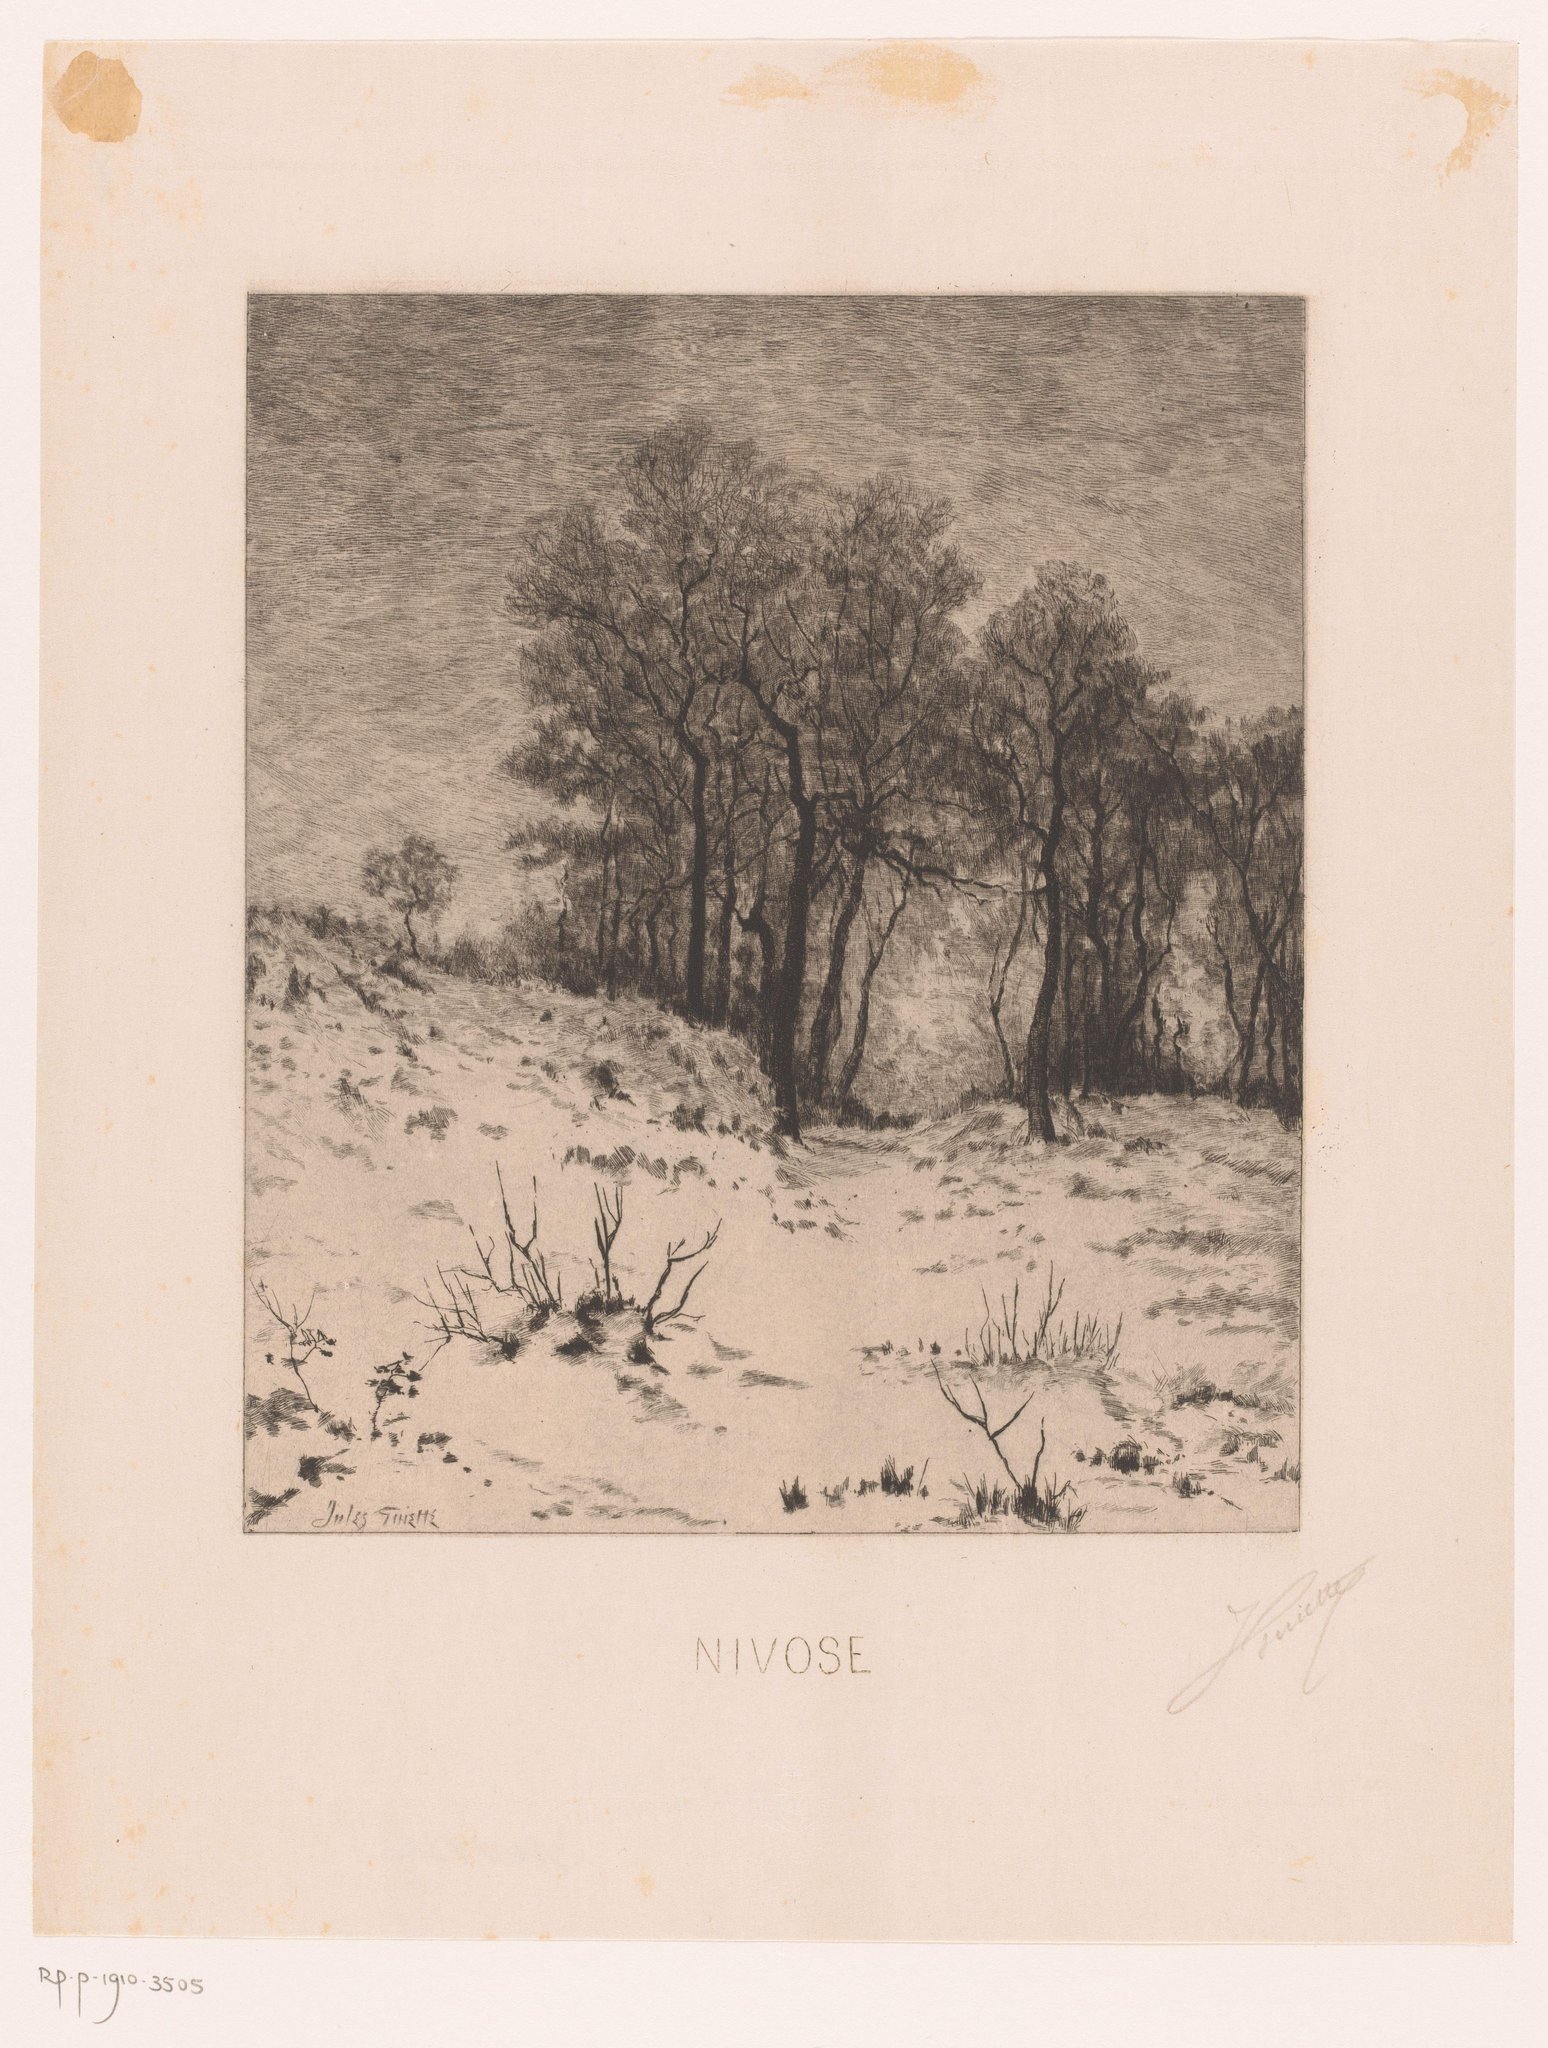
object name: print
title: Nivose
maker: jules guiette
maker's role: print maker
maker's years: 1852-1901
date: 1862-1901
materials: paper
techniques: etching, intaglio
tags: winter landscape; landscape symbolizing winter (the four seasons of the year)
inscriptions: collector's mark: Lugt 2228